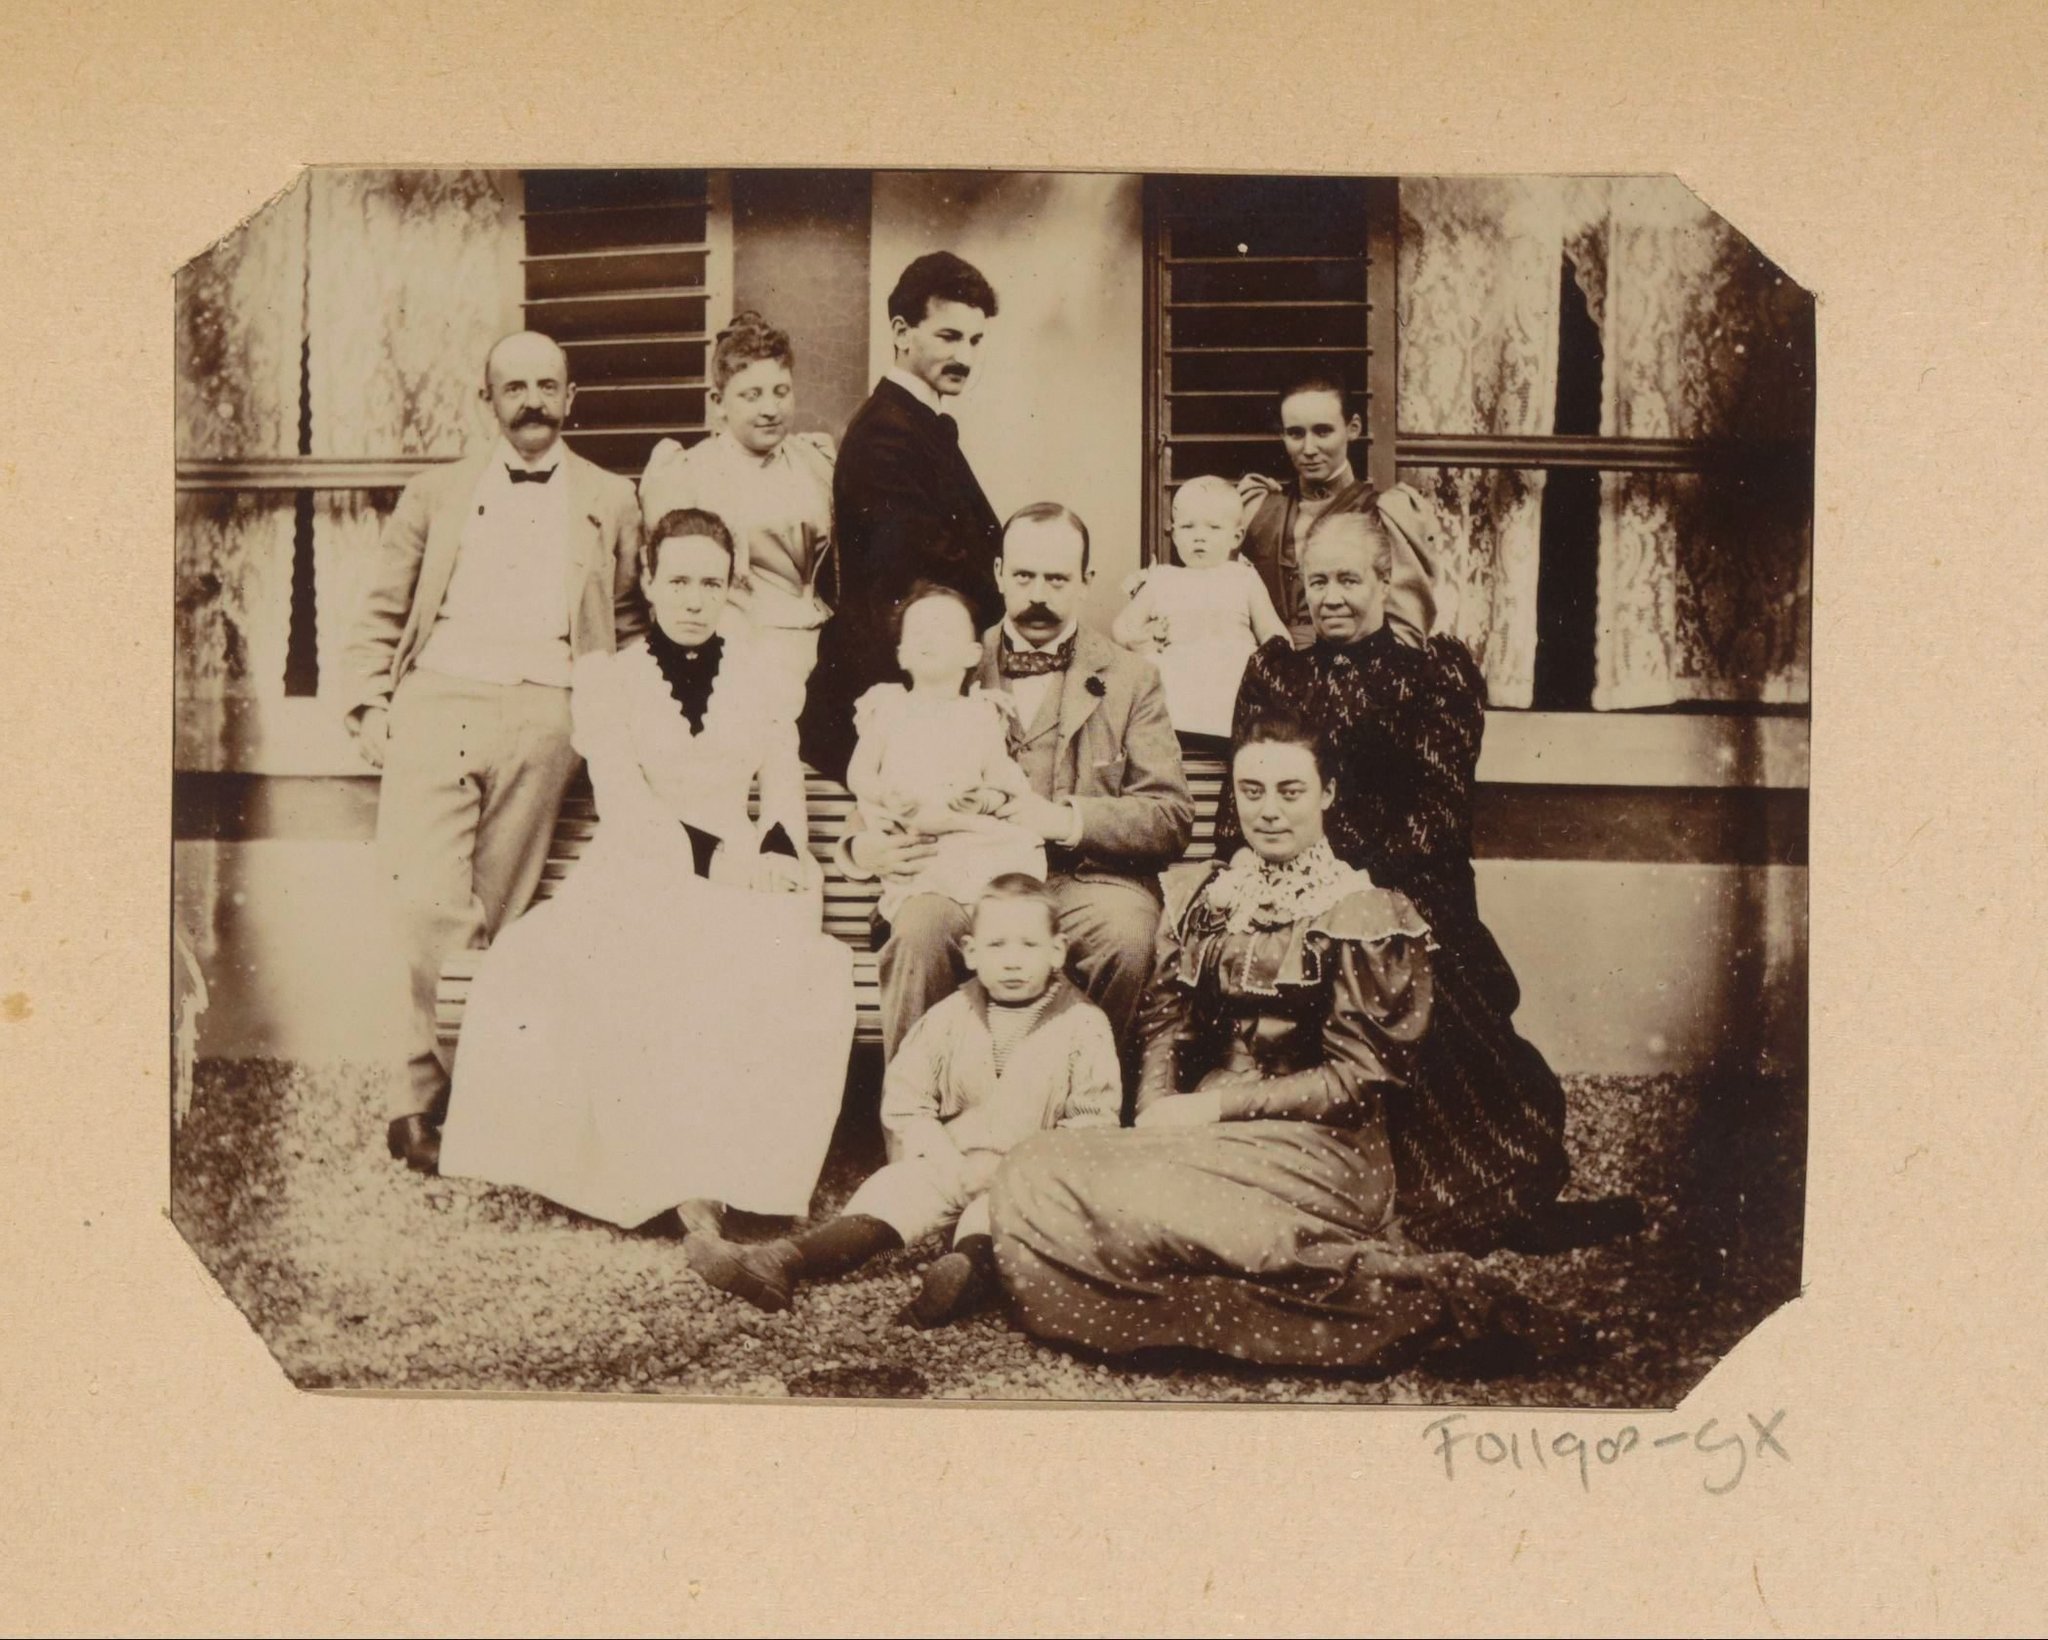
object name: photograph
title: Groepsportret van de familie Piek, v.l.n.r. Carel Overhof, Gesiena Piek, Louise Maria Fellinger, Hendrik Asser, Stephan Piek met onbekend kind, Carl Alexander Piek, Lucia Ottilia Piek, Cato Piek, Johanna Piek en Lucia Piek-Jolles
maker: willem frederik piek sr.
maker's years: 1838-1916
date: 1891-1893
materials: paper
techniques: gelatin silver print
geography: netherlands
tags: johanna margaretha piek, amsterdam, family life, anonymous historical persons portrayed in a group, in a group-portrait, netherlands